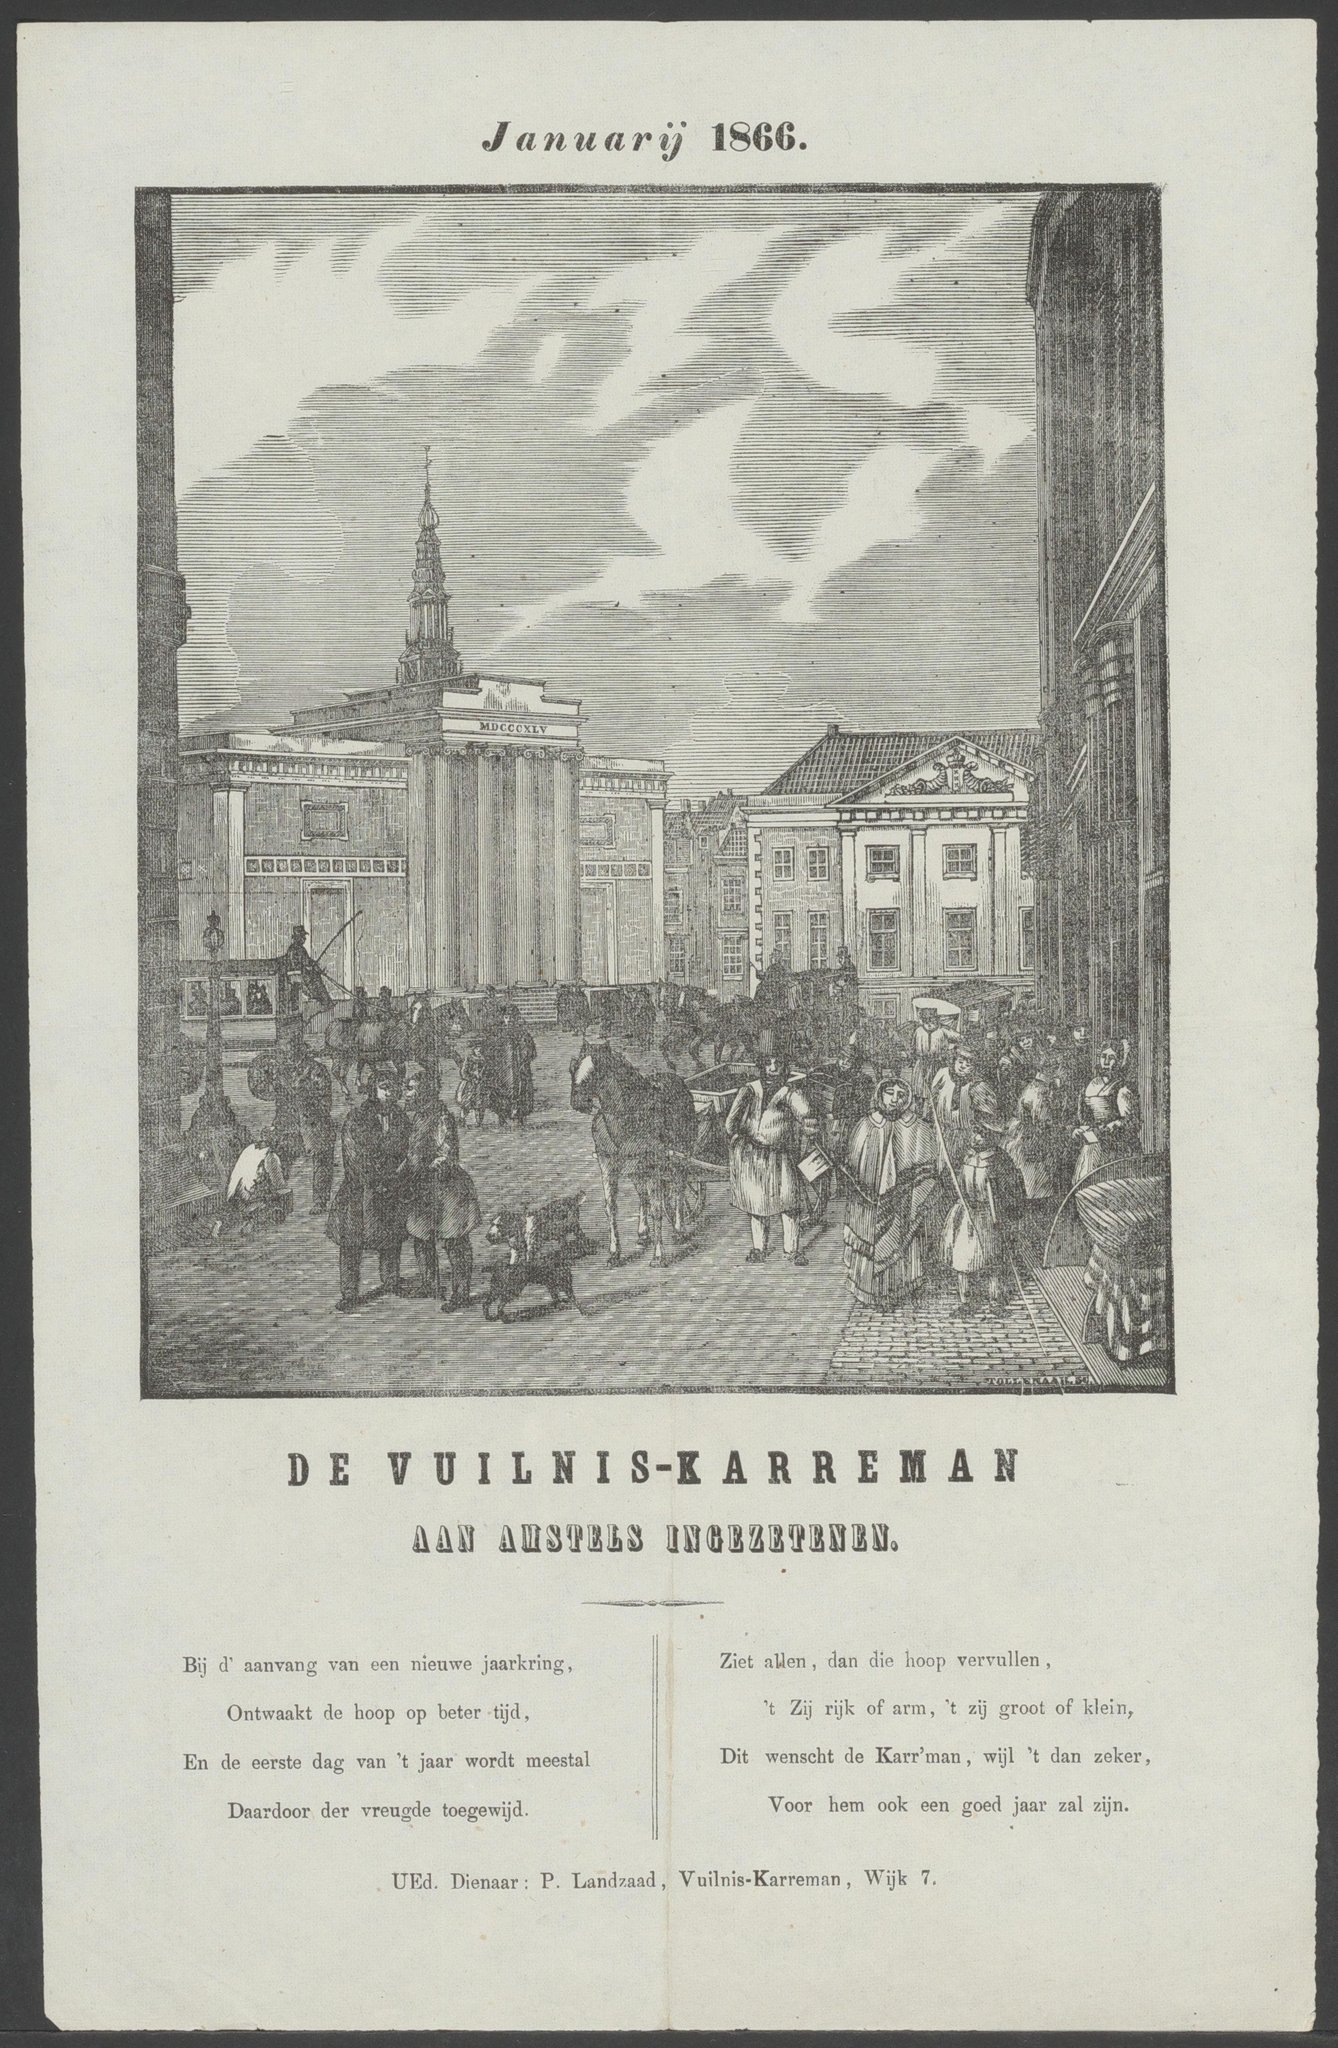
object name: print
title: De Vuilnis-karreman aan Amstels ingezetenen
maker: dirk wijbrand tollenaar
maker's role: print maker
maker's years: 1808-1858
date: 1866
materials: paper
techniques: letterpress printing, engraving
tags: street, garbage collection, amsterdam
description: Nieuwjaarswens van de Amsterdamse vuilnismannen voor het jaar 1856. Gezicht op de Dam met de Beurs van Zocher en het Commandantshuis te Amsterdam. Tussen het publiek de vuilnismannen met hun kar. Met gedicht in twee kolommen. Van de vuilniskarman in de wijk no. 7: P. Landzaad. Onderwerpsrubrieken binnen de Atlas Zeden en Gewoonten: Zeden en gewoonten in engeren zin, Volksleven, Volksbladen, Nieuwjaars- en Kerstwenschen, Amsterdam.